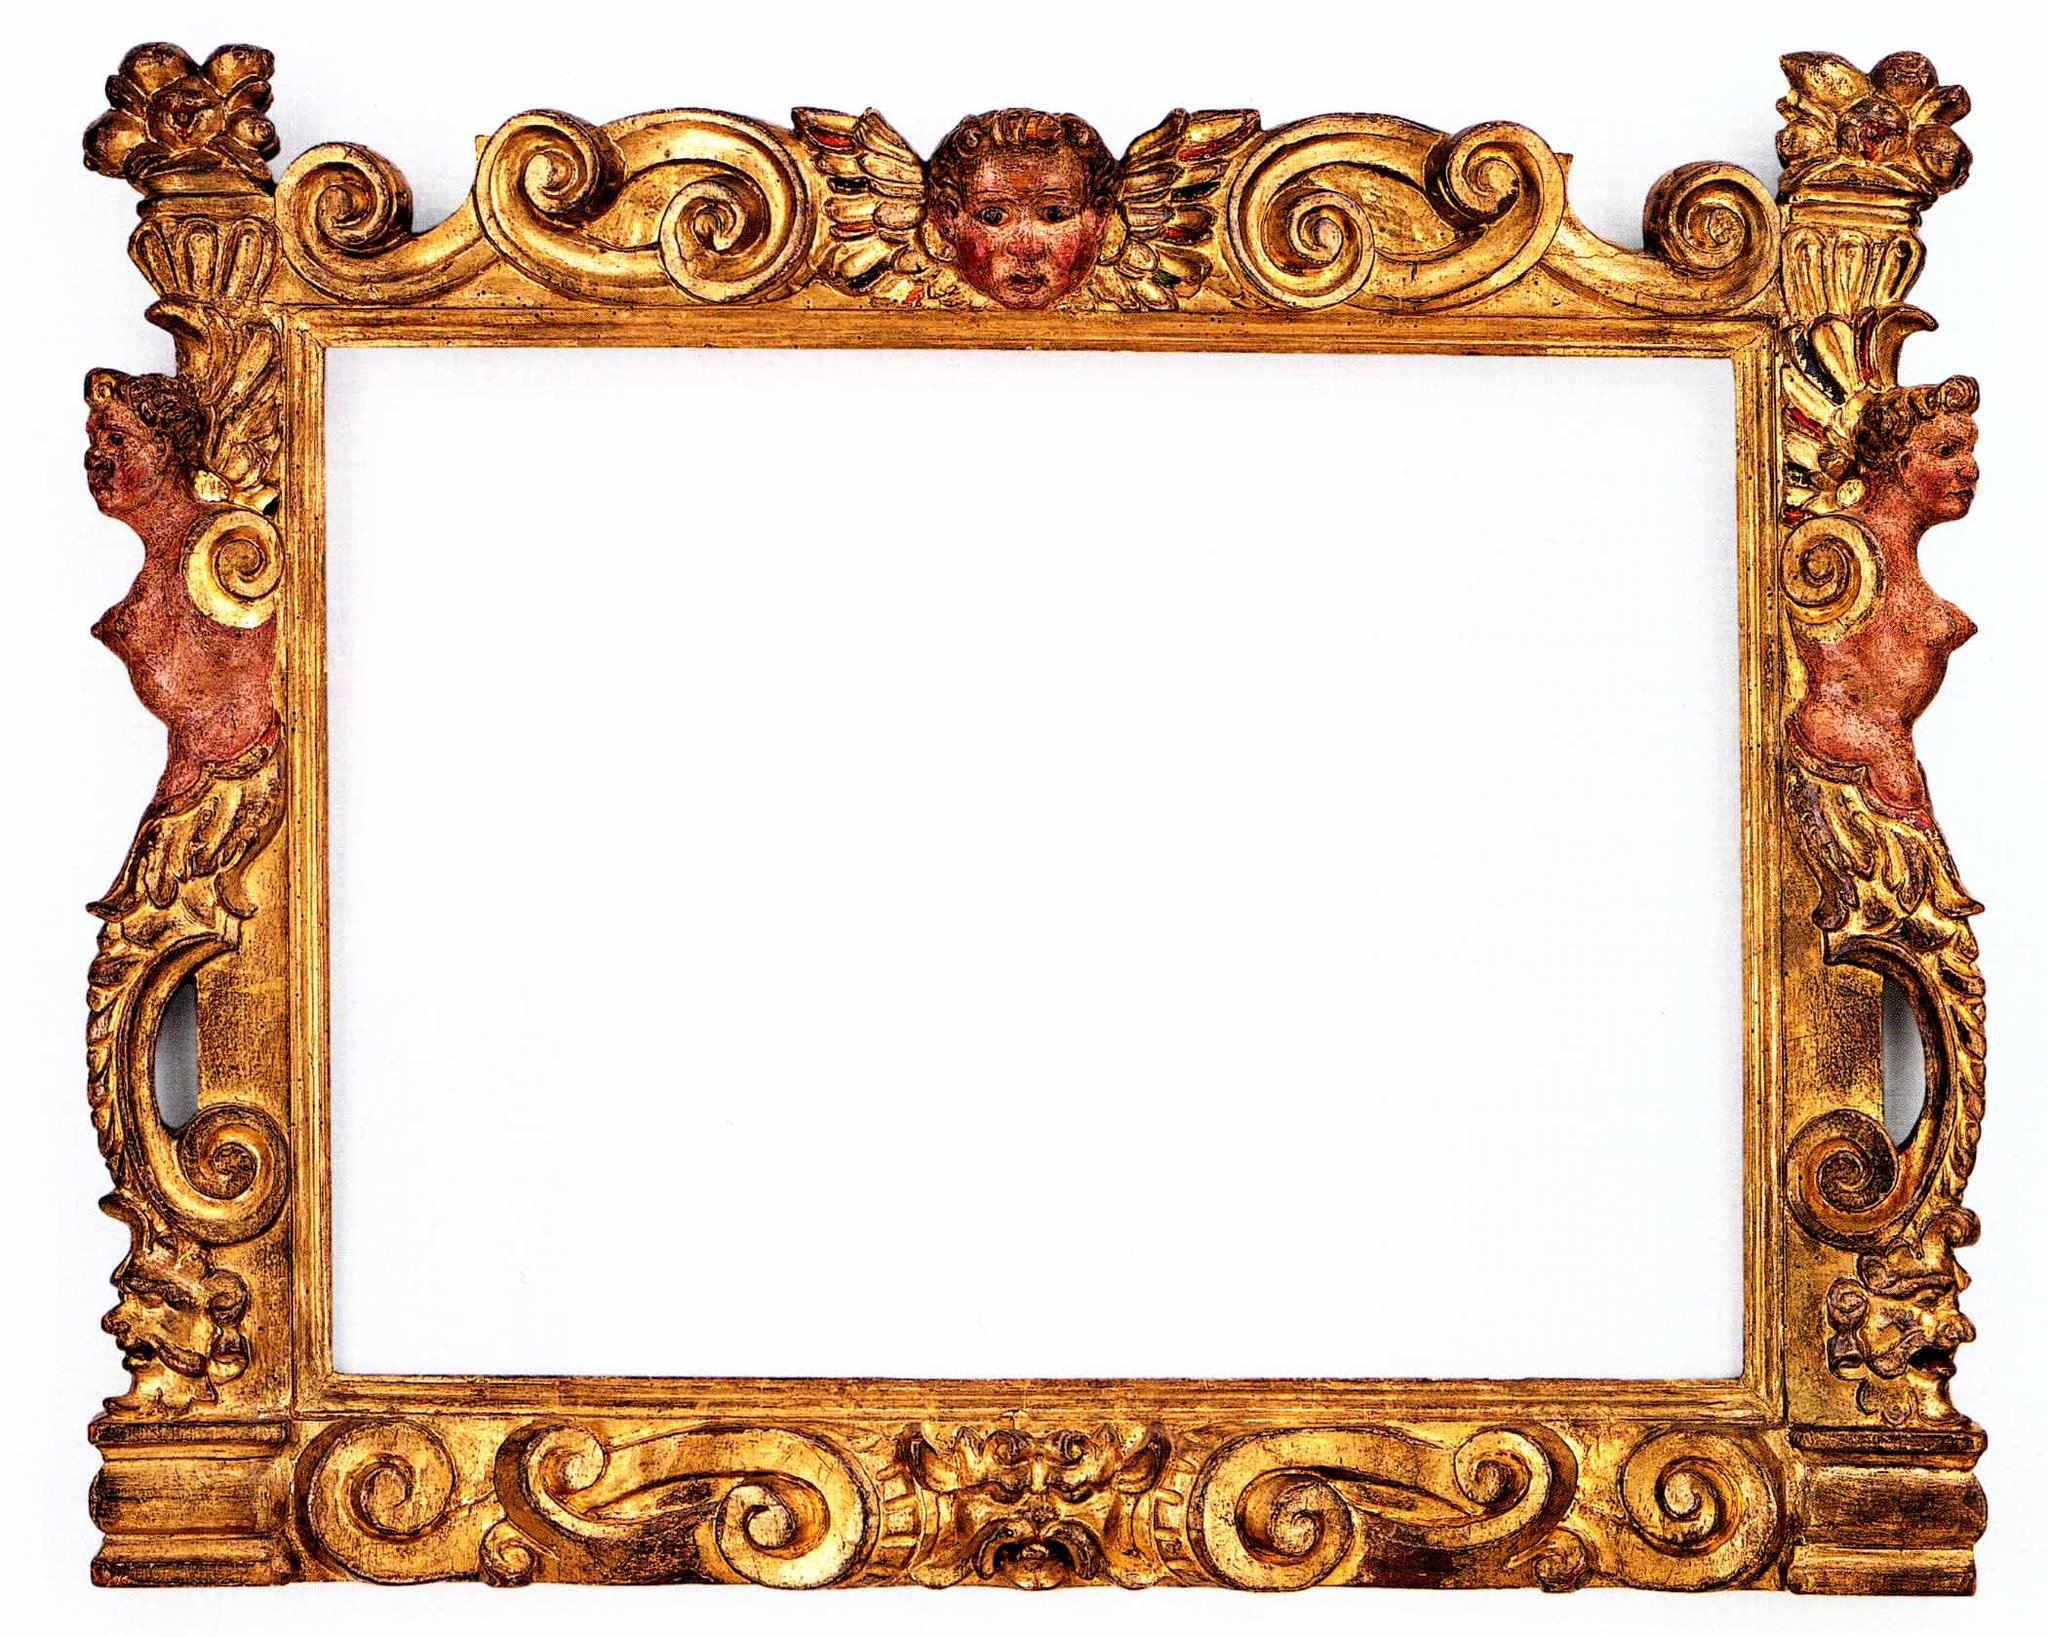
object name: frame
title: Sansovino-style frame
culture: italian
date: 1534-1566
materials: gesso, gilt, glaze, wood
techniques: carving